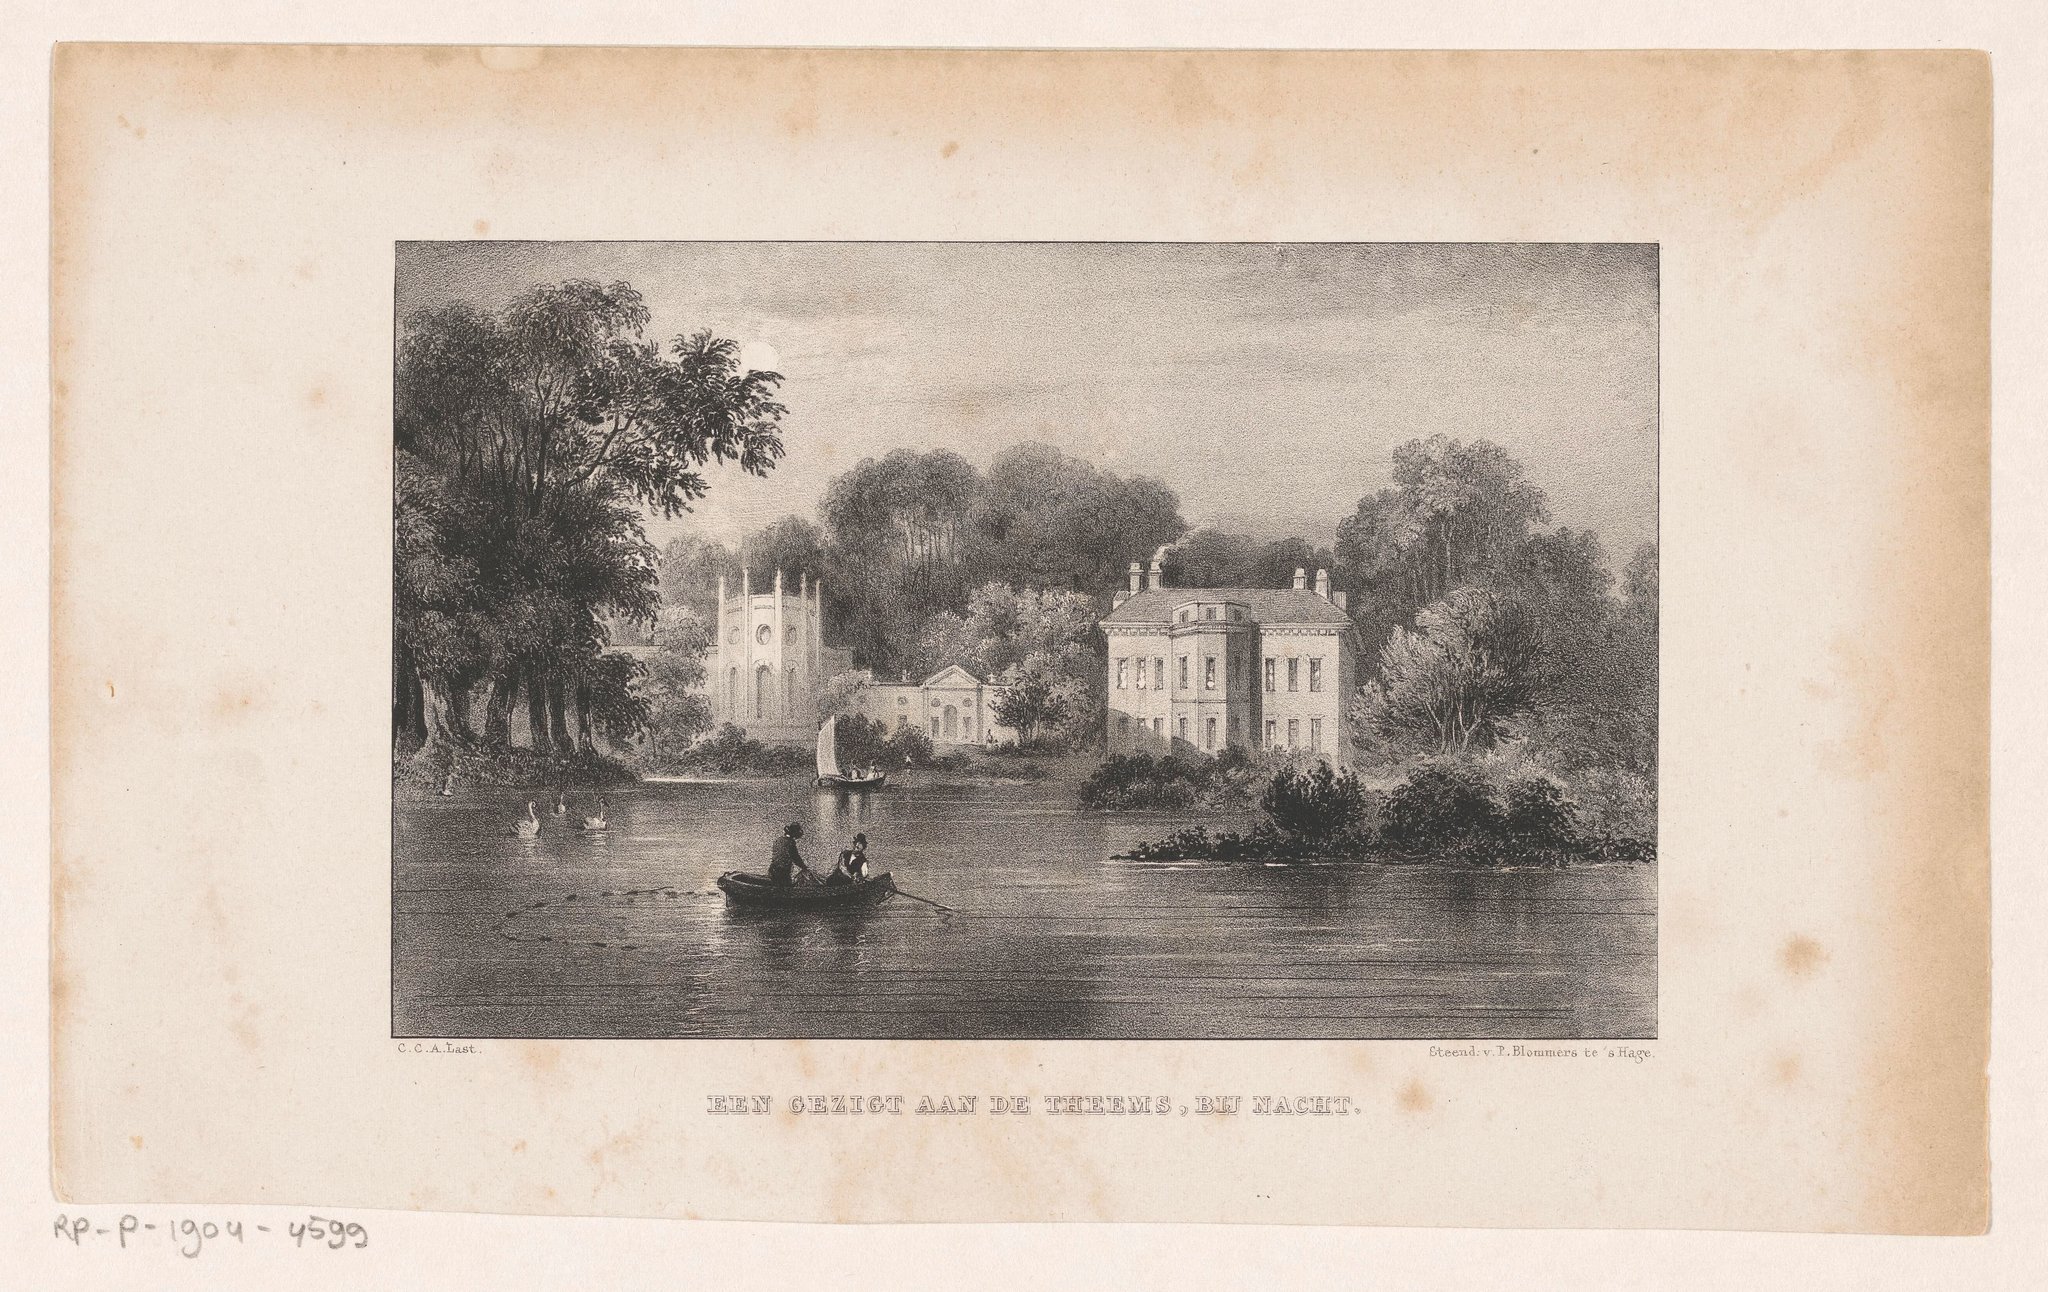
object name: print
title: Gezicht op de Theems bij nacht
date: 1842-1887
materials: paper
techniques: lithograph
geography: the hague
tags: sailing-ship, sailing-boat, rowing-boat, canoe, etc., river (+ landscape with figures, staffage), night, thames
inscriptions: collector's mark: Lugt 2228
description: Op het water een roei- en zeilboot. Aan de oever landhuizen.